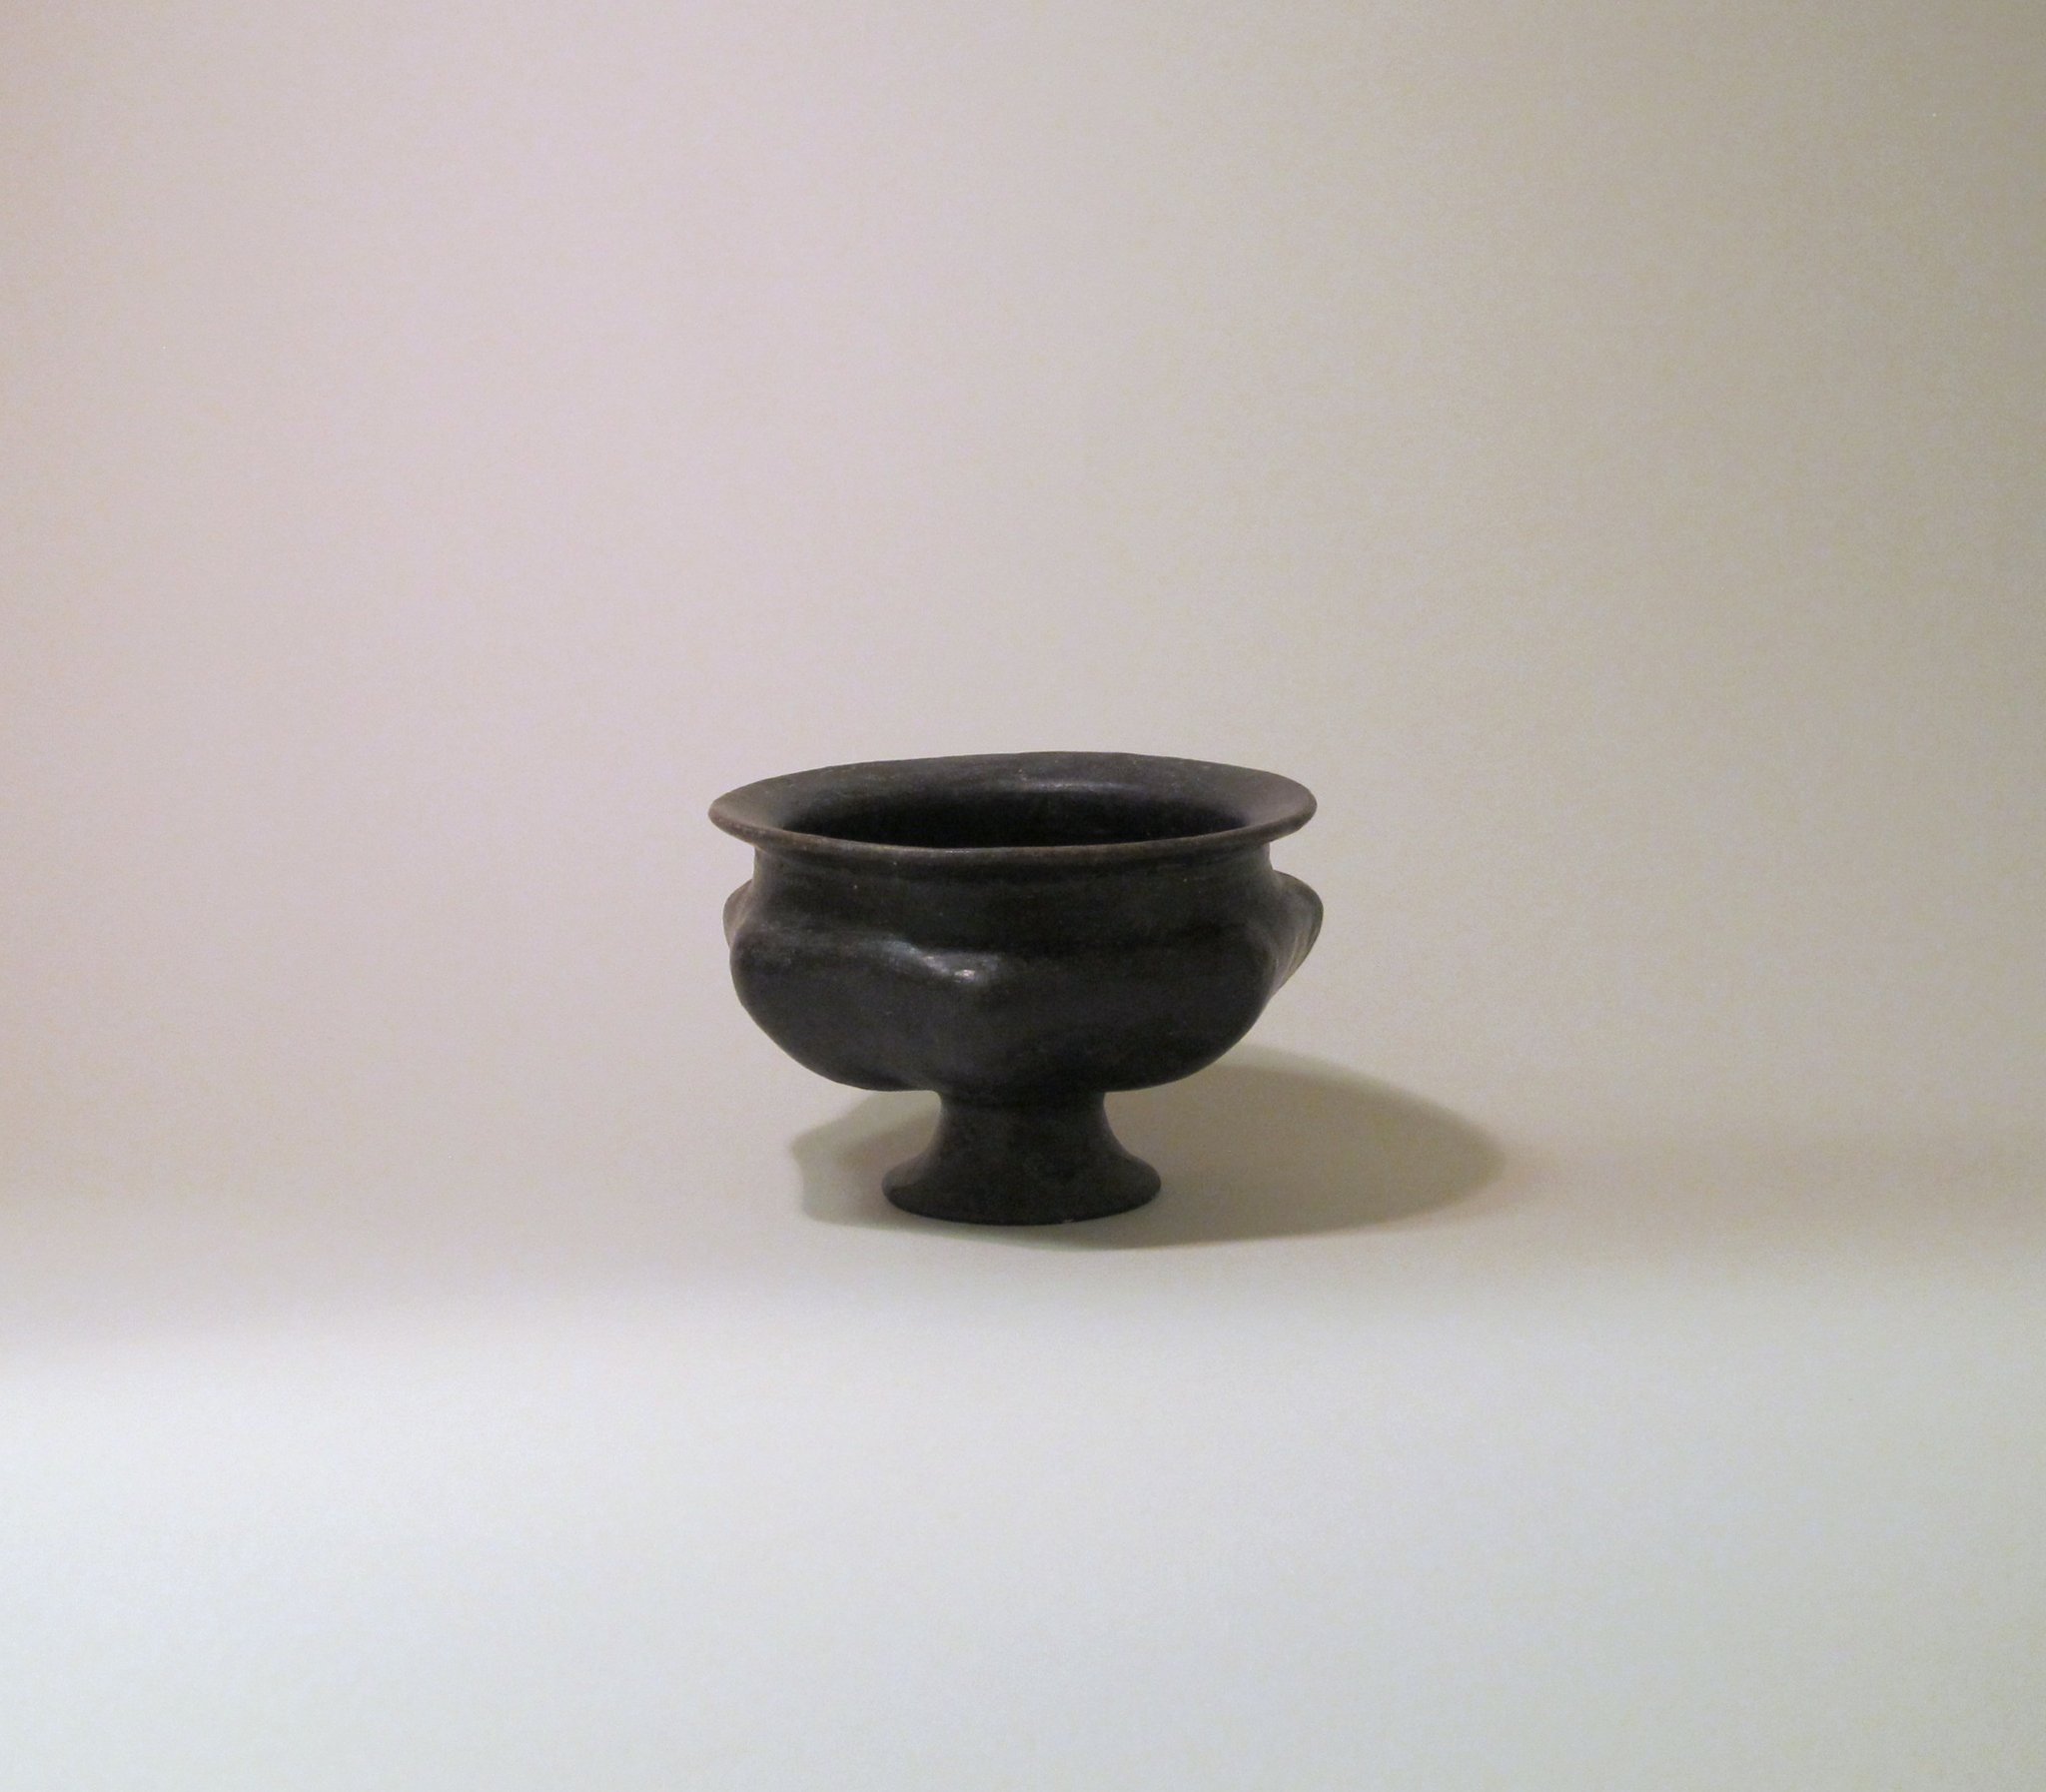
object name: jar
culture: etruscan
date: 700-651 BCE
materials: terracotta